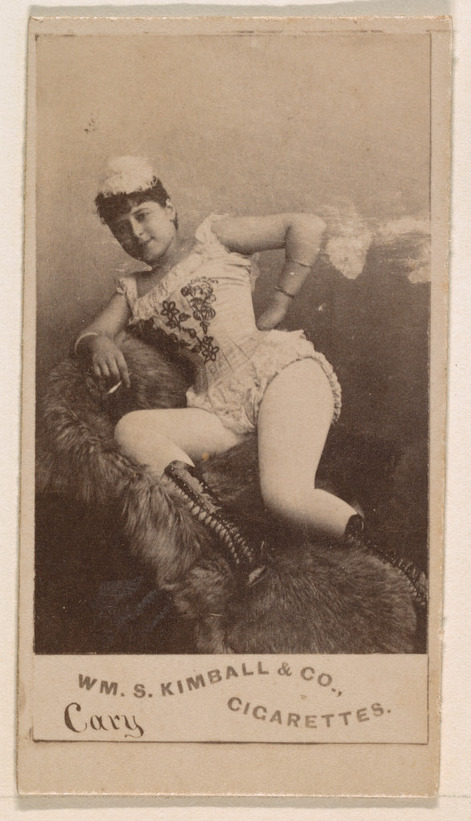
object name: photograph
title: Miss Cary, from the Actresses series (N203) issued by Wm. S. Kimball & Co.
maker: william s. kimball & company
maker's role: publisher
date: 1889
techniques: color lithograph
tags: portraits,women,actresses